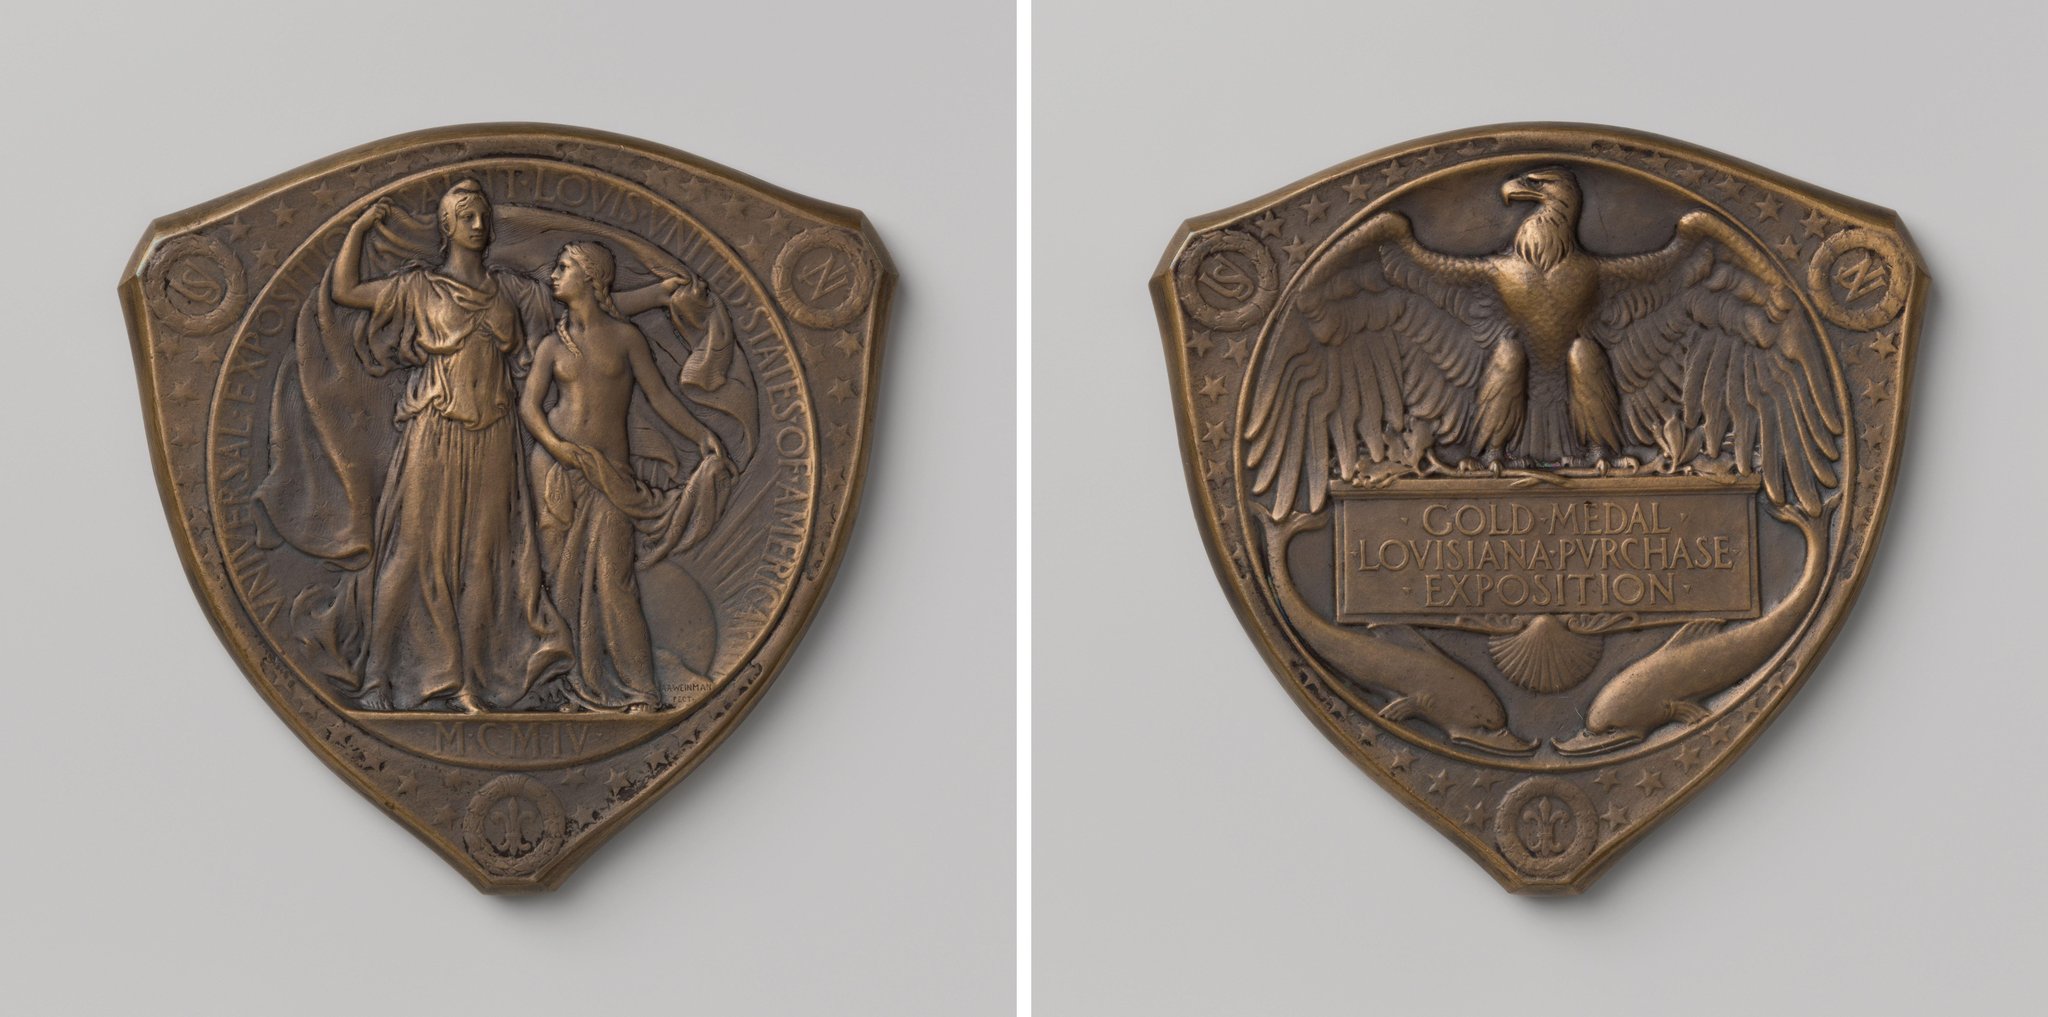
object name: medal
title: Louisiana Purchase-tentoonstelling te Saint-Louis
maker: adolph alexander weiman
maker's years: 1870-1923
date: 1904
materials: bronze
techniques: striking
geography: new york city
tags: predatory birds: eagle, personifications of countries, nations, states, districts, etc., phrygian bonnet